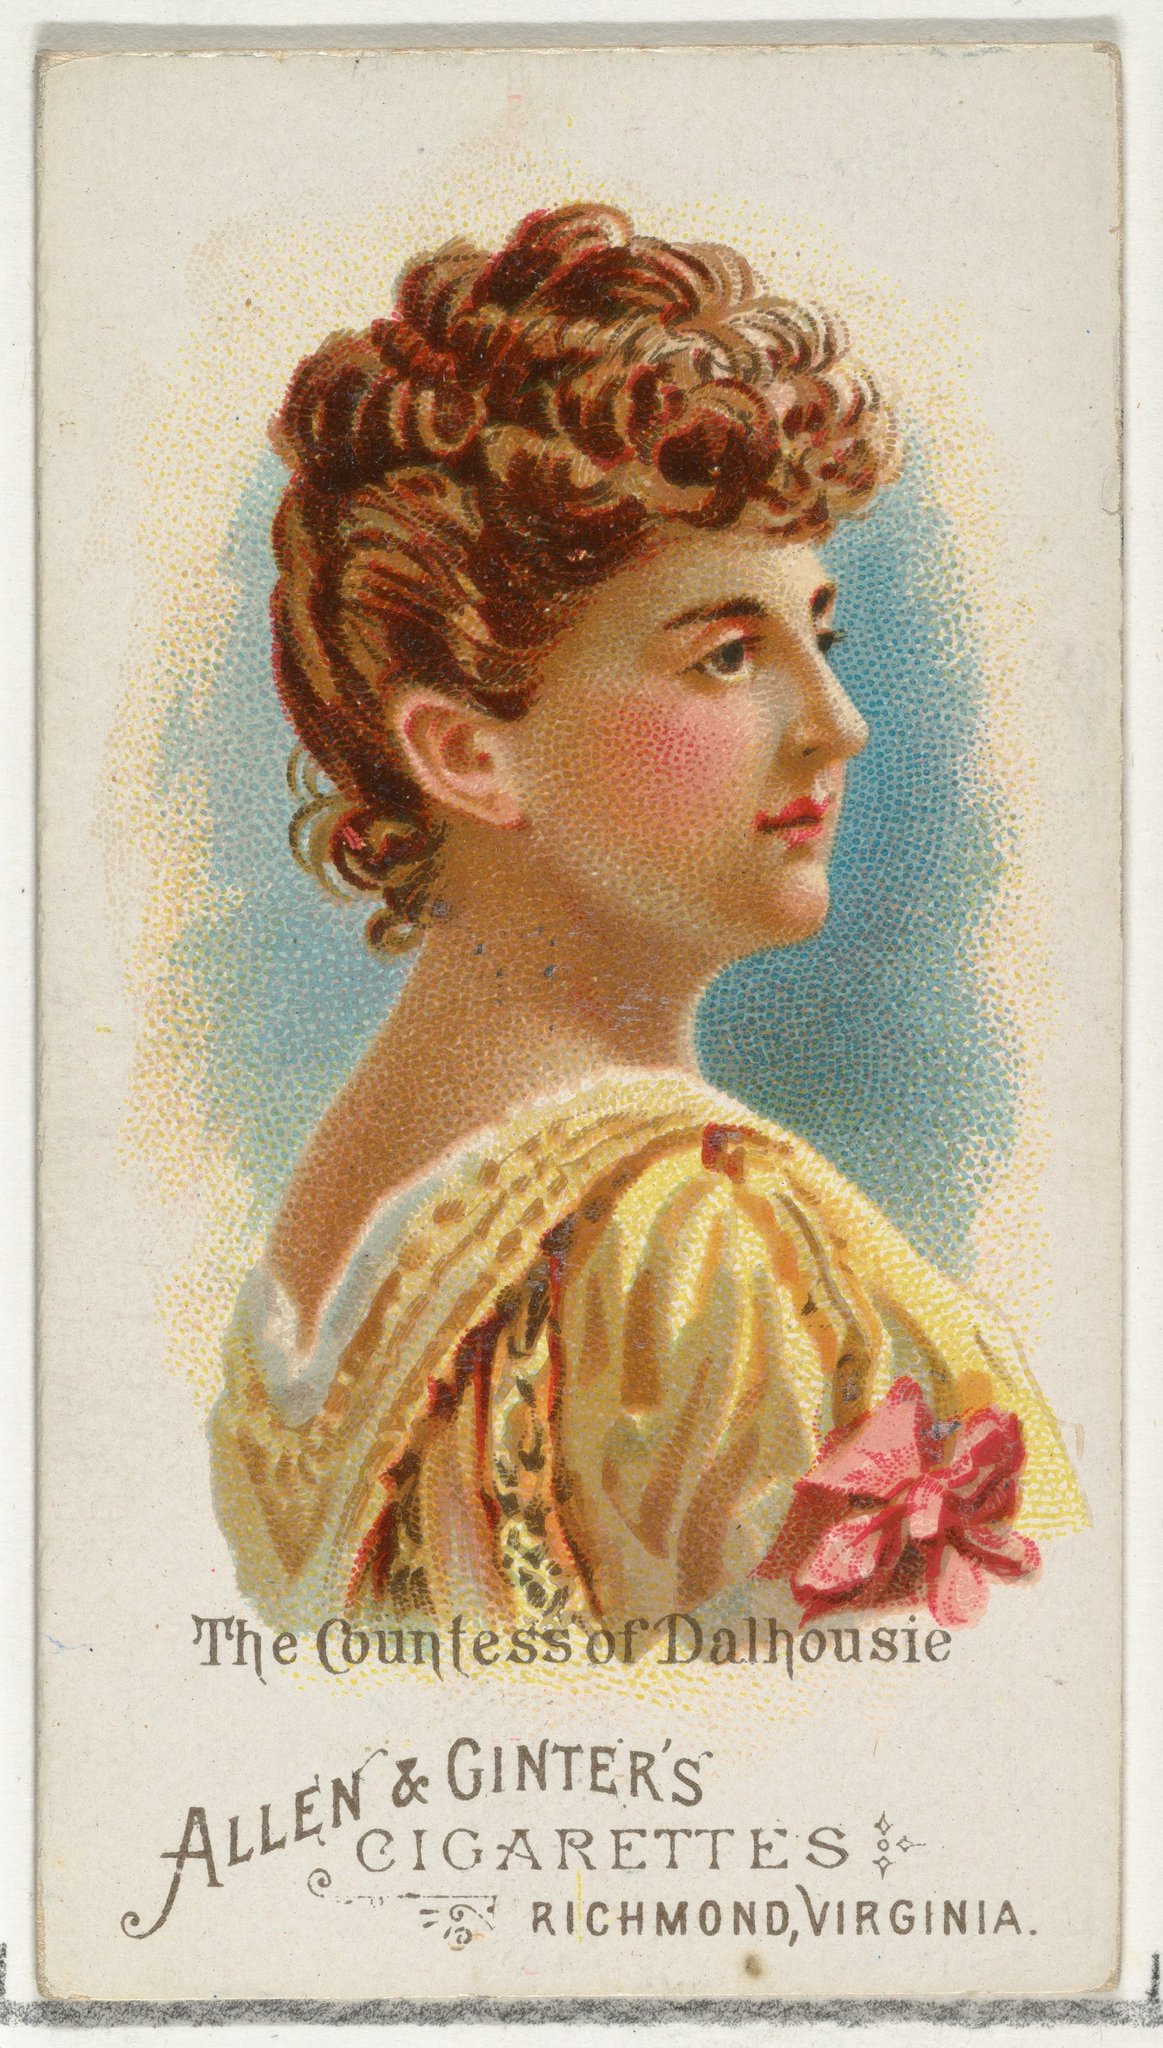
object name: print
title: The Countess of Dalhousie, from World's Beauties, Series 1 (N26) for Allen & Ginter Cigarettes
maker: allen & ginter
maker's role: publisher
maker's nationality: american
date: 1888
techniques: color lithograph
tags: women